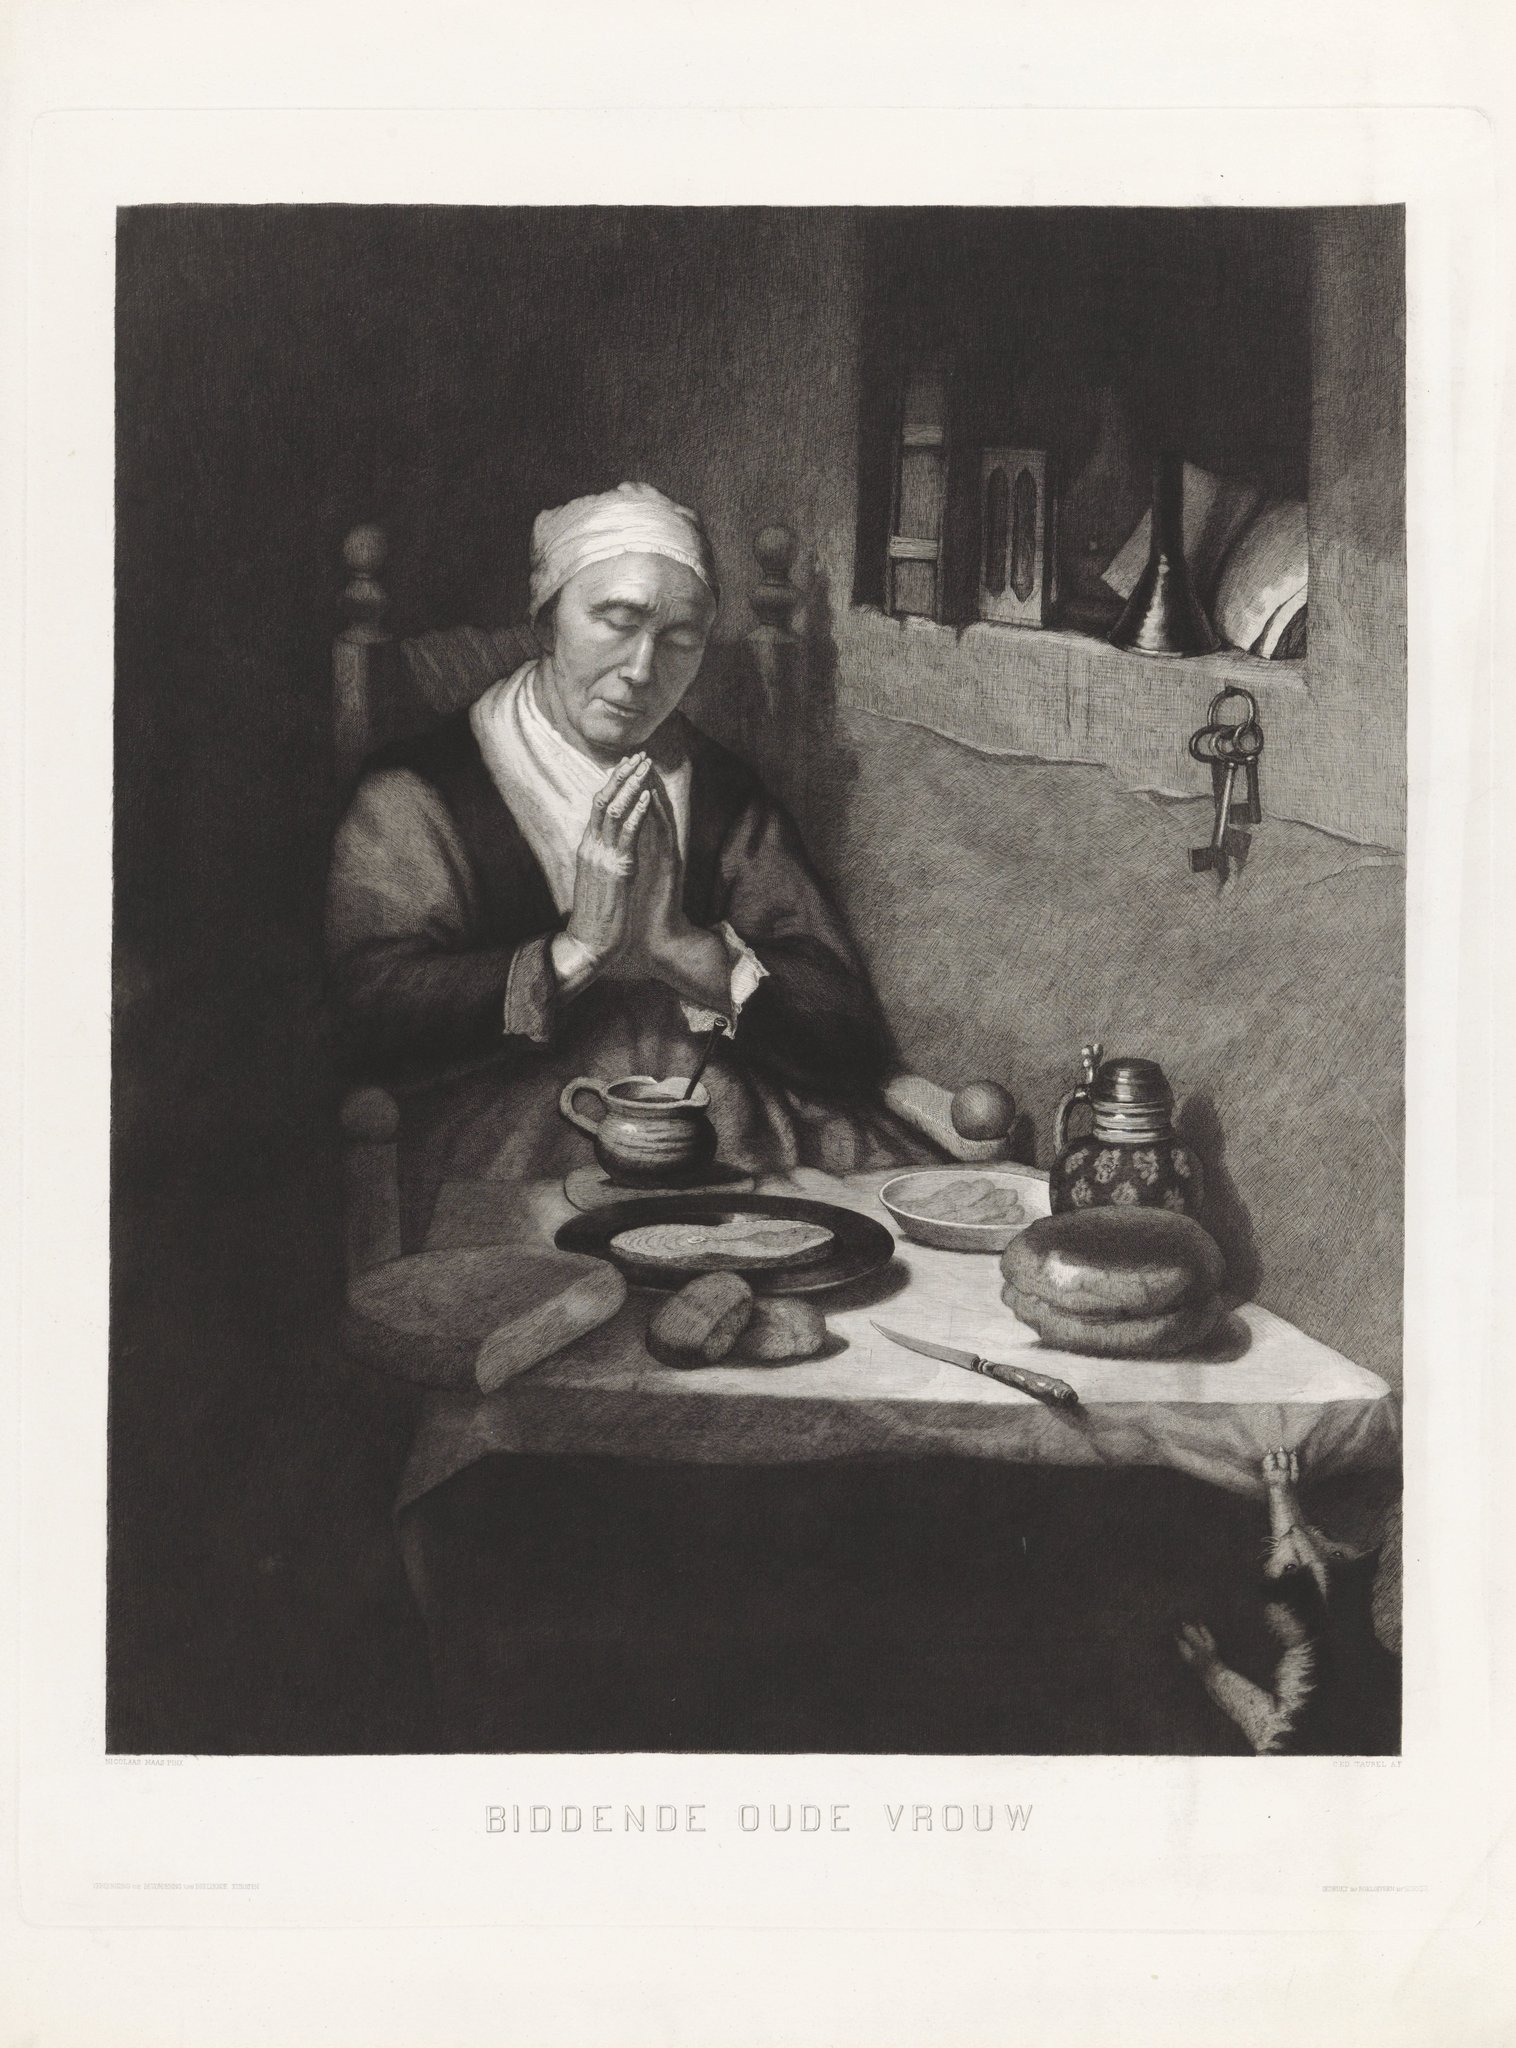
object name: print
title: Biddende oude vrouw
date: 1834-1892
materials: paper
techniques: engraving, etching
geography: amsterdam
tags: evening meal, dinner, supper, laid table: table-ware, table-decoration, etc., one person praying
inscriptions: collector's mark: Lugt 2228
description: Voorstelling bekend onder de titel 'Het gebed zonder end'. Een met gevouwen handen biddende oude vrouw, zittend aan een gedekte tafel met brood, kaas, een kruik, een kom en een bord met vis. Rechts trekt een kat aan het tafelkleed. Rechts een nis in de muur met sleutels, een trechter en een zandloper.